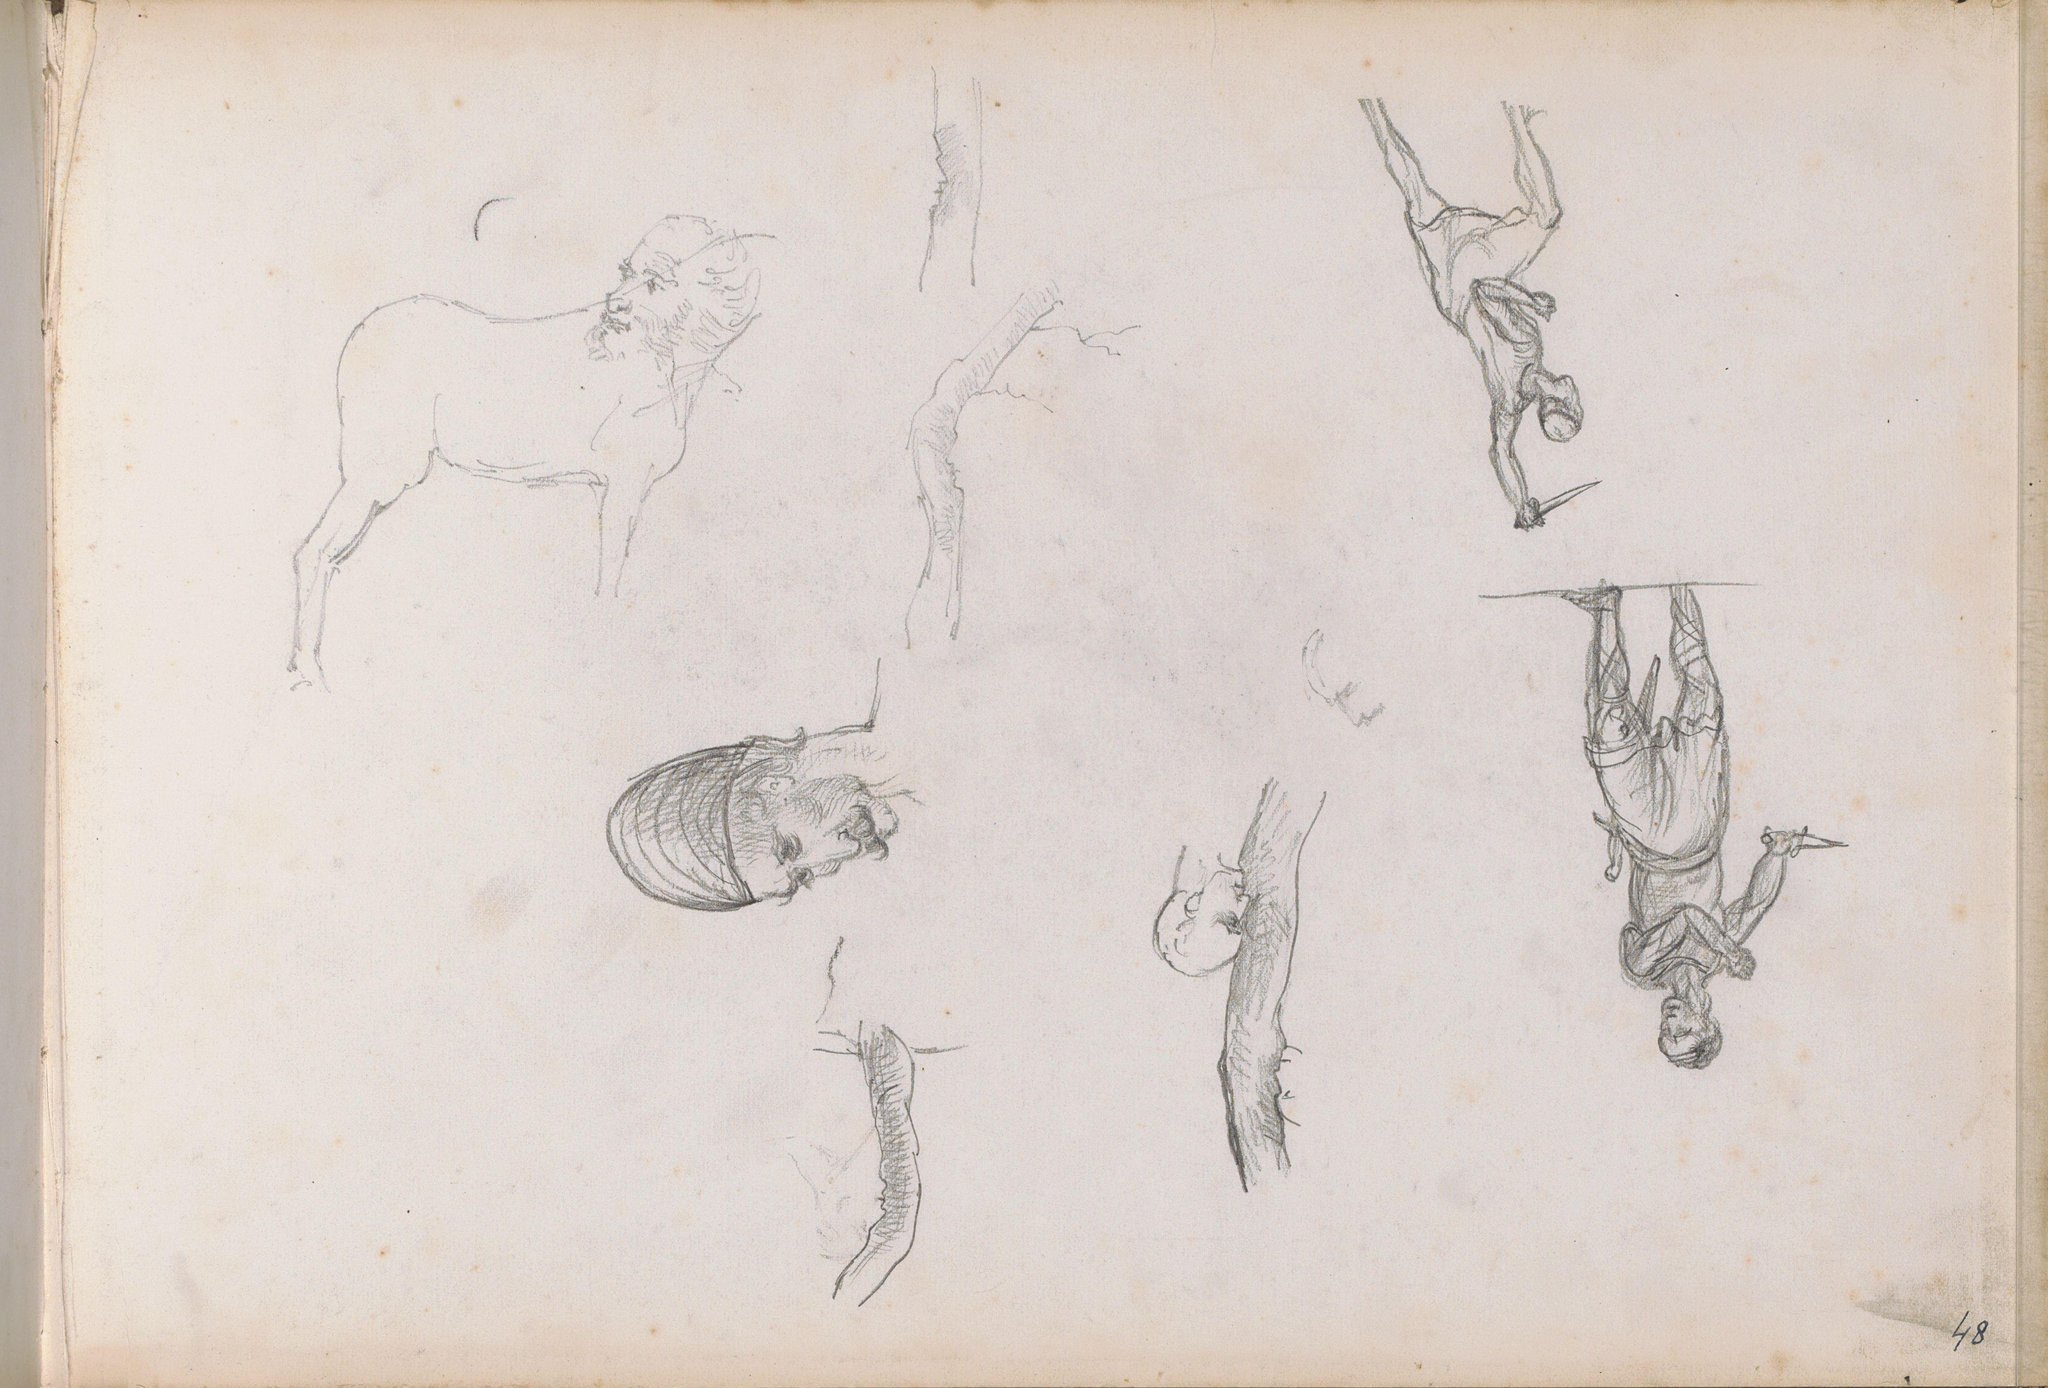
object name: sketchbook leaf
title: Paard en figuurstudies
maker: george hendrik breitner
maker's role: draughtsman, painter, print maker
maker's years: 1857-1923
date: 1873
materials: paper, pencil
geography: rotterdam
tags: head (human), hacking and thrusting weapons: dagger, adult man, horse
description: Blad 48, achterste schutblad, uit een schetsboek met 25 bladen.